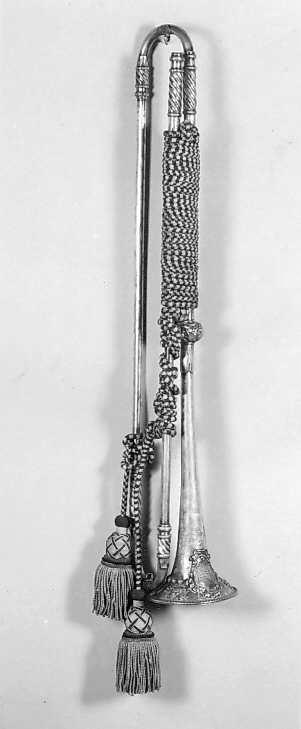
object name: natural trumpet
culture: austrian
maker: anton kerner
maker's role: maker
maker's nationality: austrian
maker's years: 1726-1806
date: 1765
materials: silver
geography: austria